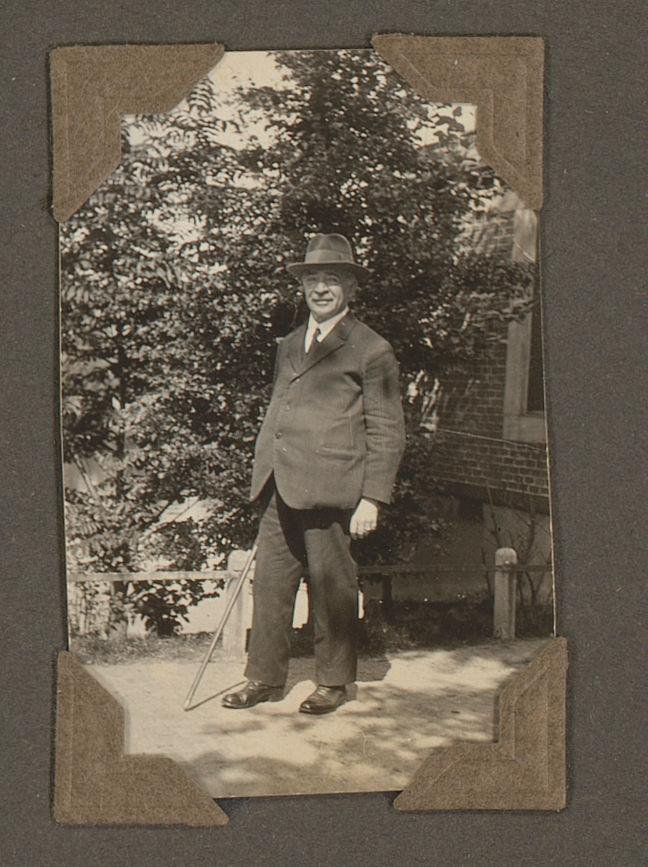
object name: album leaf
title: Portret van een man met hoed en wandelstok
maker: Anonymous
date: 1920-1940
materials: photographic support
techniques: gelatin silver print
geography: netherlands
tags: walking-stick, staff, adult man, historical persons, head-gear: hat